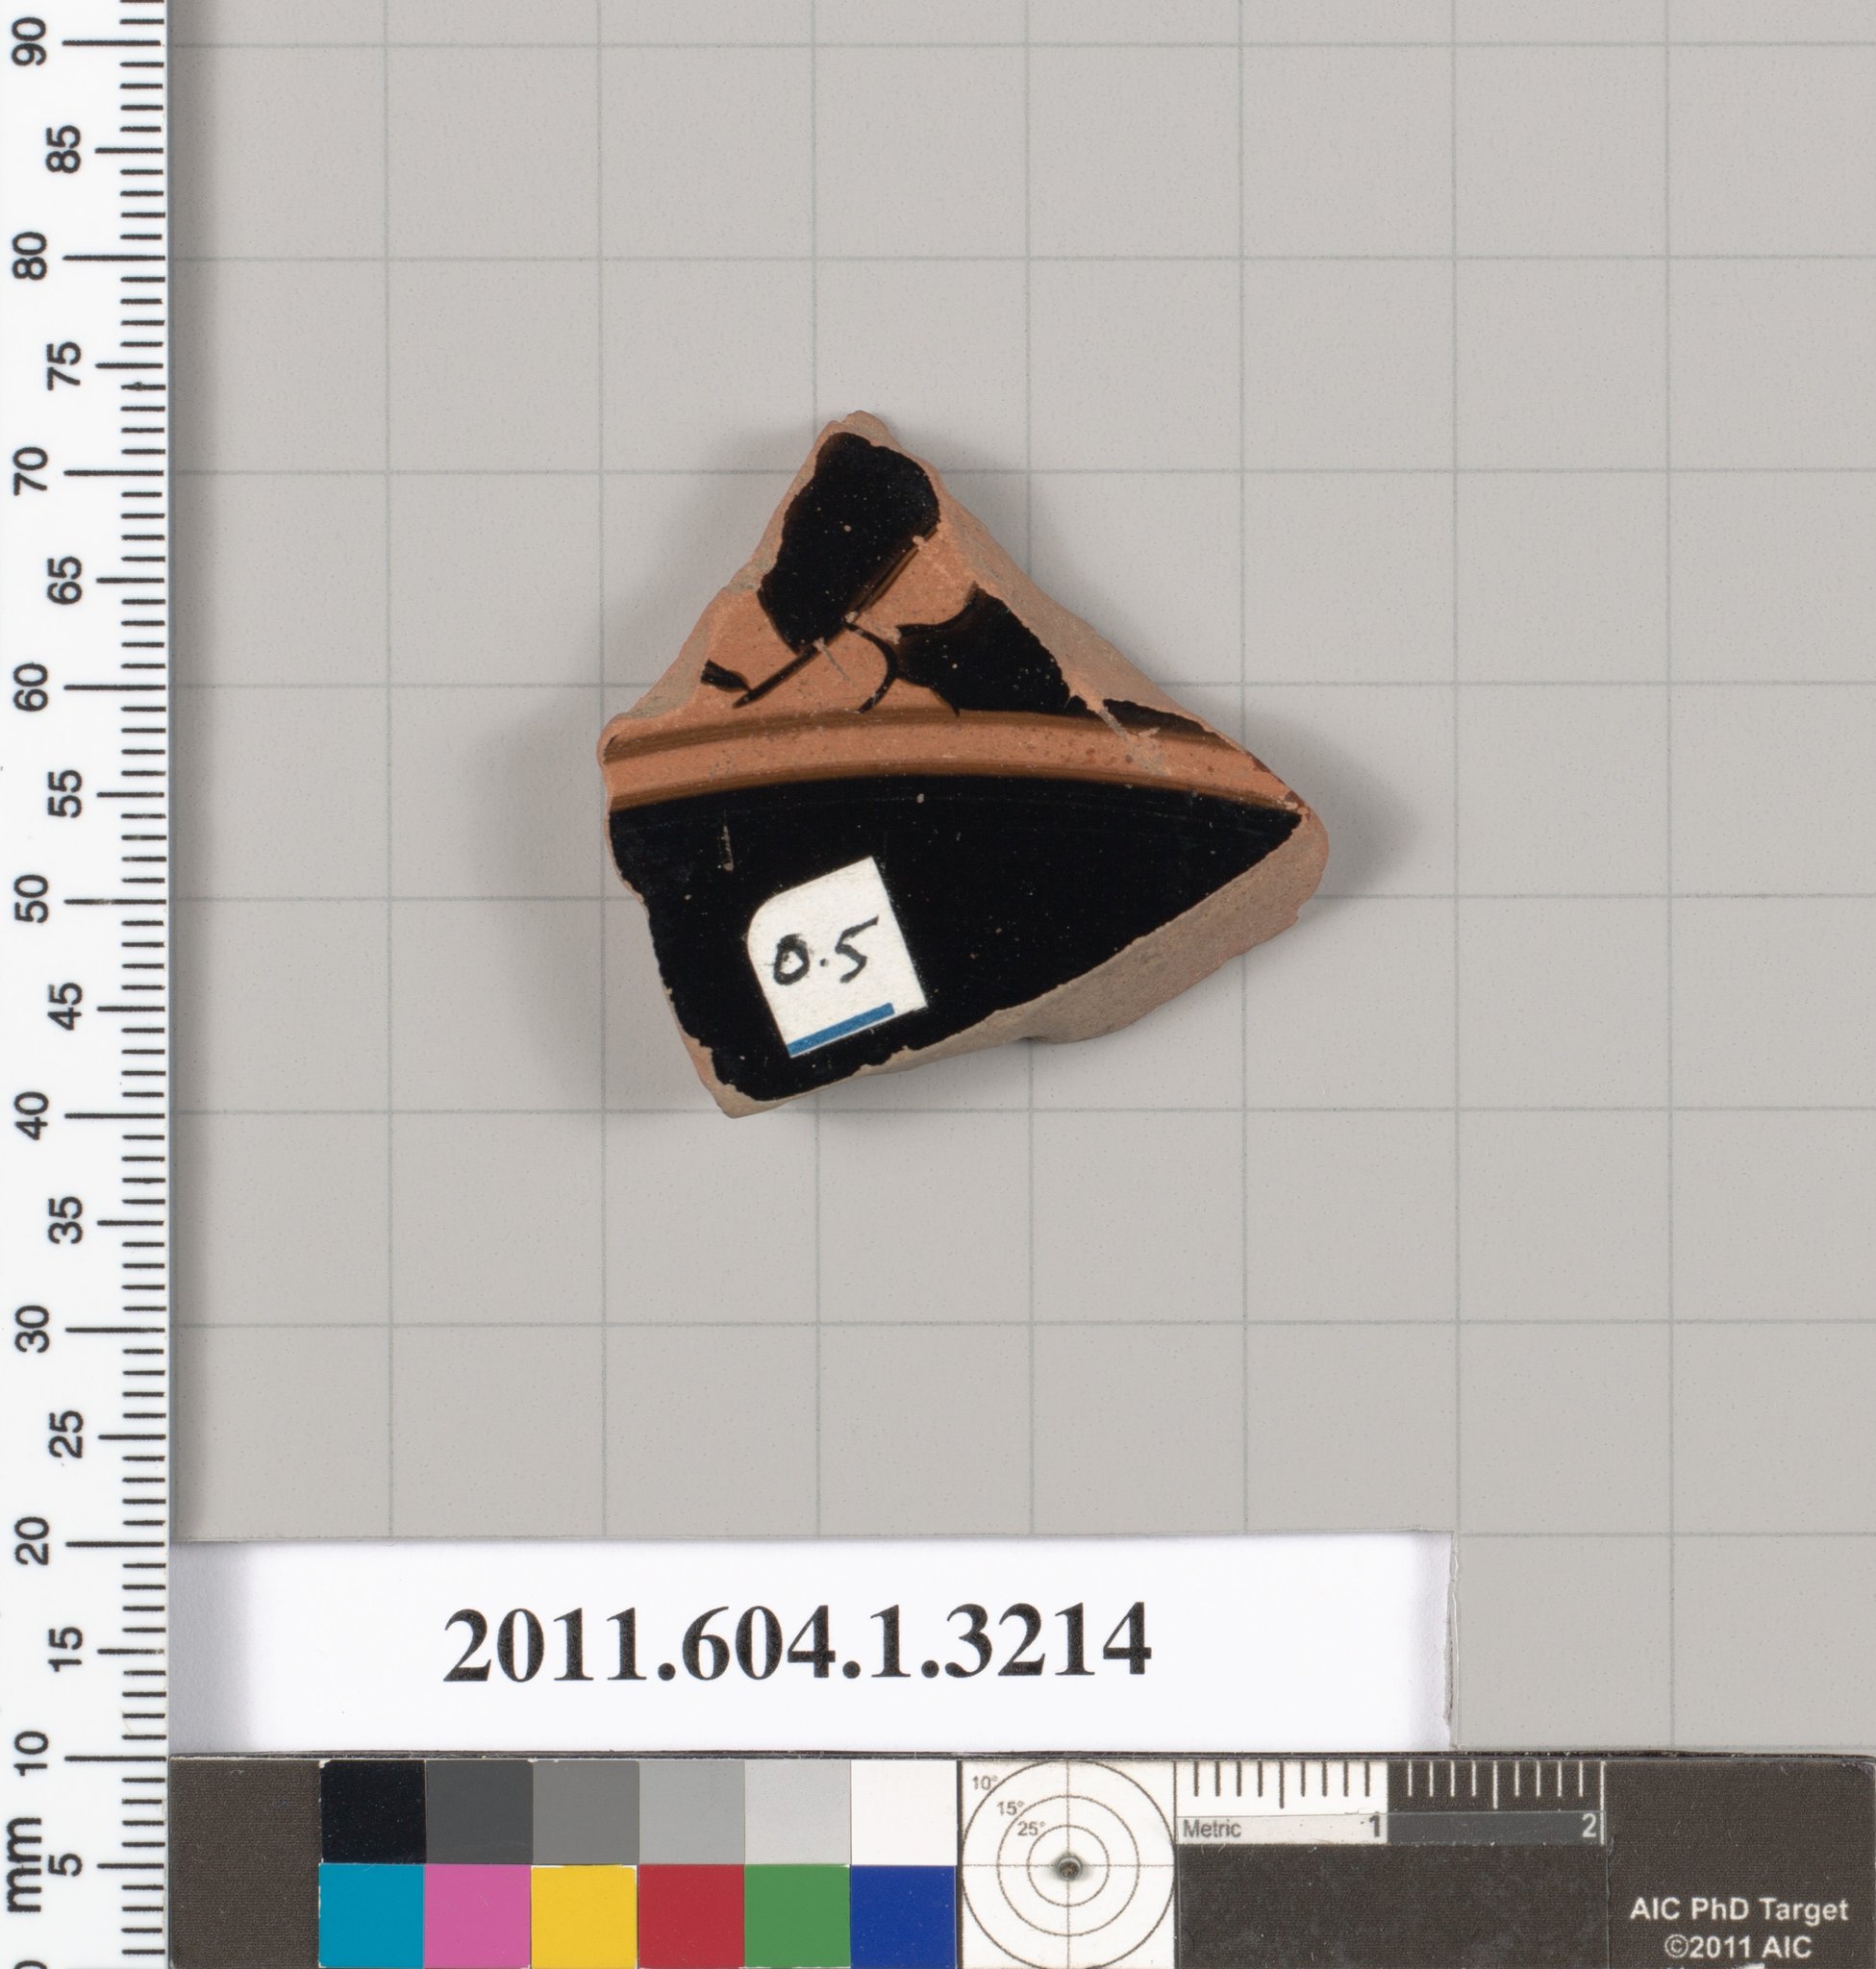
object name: kylix fragment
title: Terracotta fragment of a kylix (drinking cup)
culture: greek, attic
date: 475-451 BCE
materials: terracotta